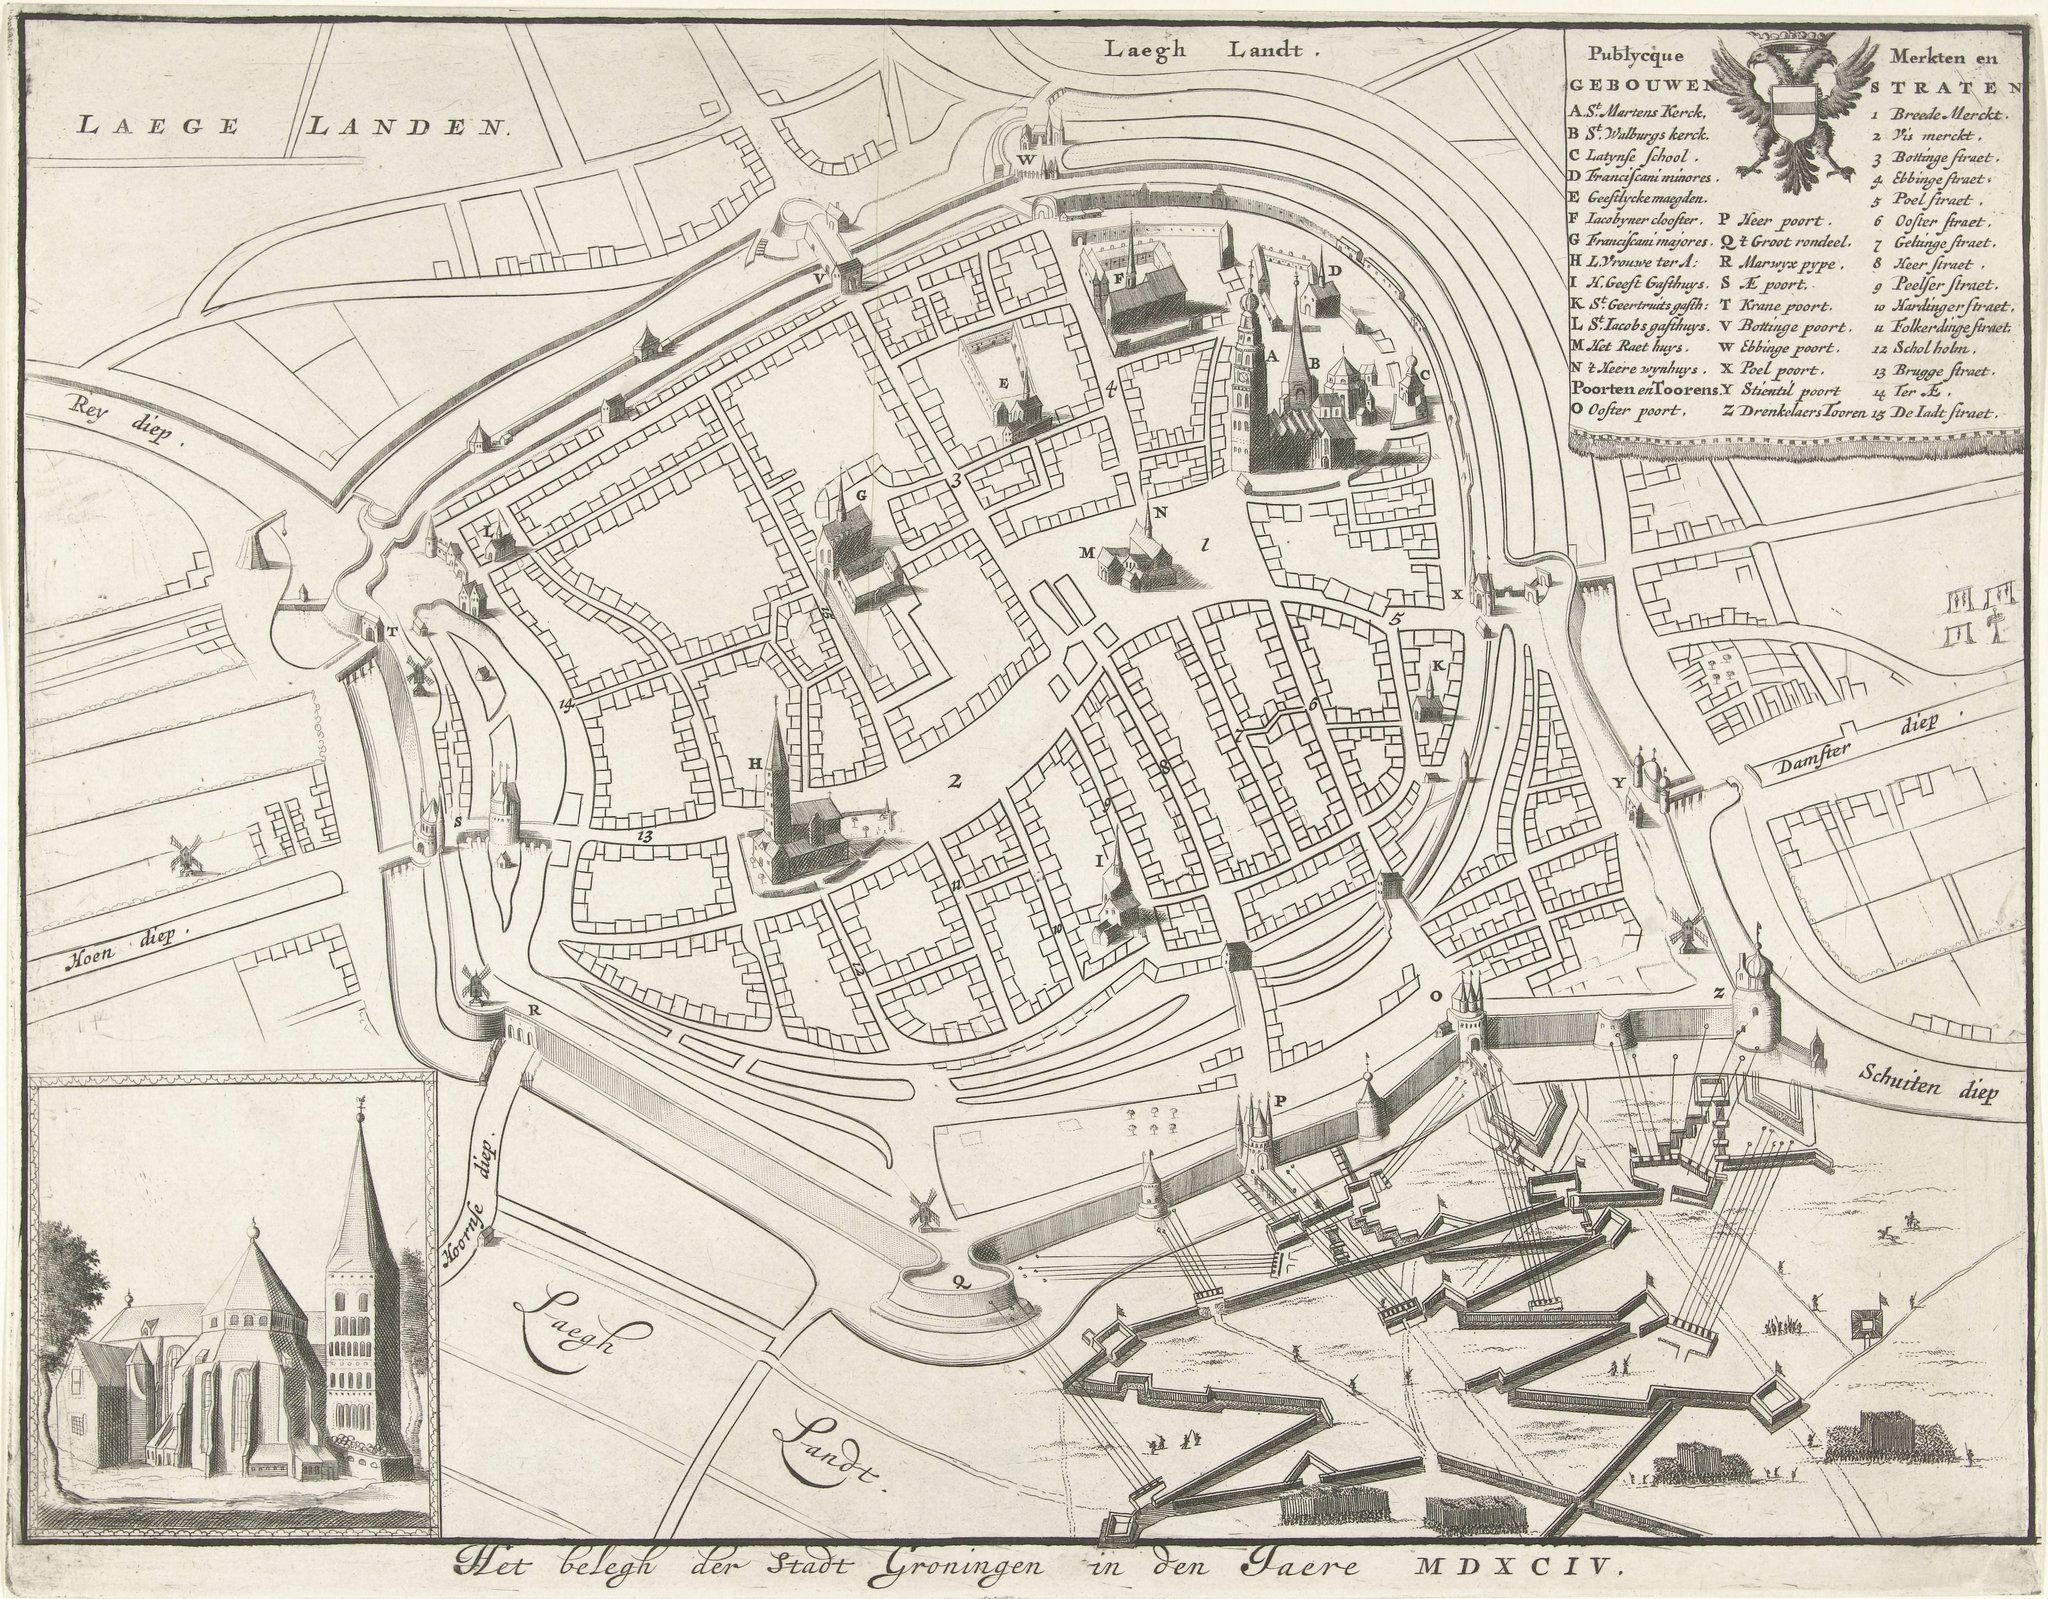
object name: history print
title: Het belegh der stadt Groningen in den jaere MDXCIV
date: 1681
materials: paper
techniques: engraving, etching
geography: amsterdam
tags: coat of arms (as symbol of the state, etc.), siege, position war, maps of cities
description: Plattegrond in vogelvluchtperspectief van Groningen tijdens het beleg door het Staatse leger onder Maurits in 1594. Onderaan de loopgraven en wallen van het leger van de prins. Linksonder een afbeelding van de Sint Walburgskerk, rechtsboven het wapen van de stad en de legenda A-Z en 1-15 in het Nederlands.